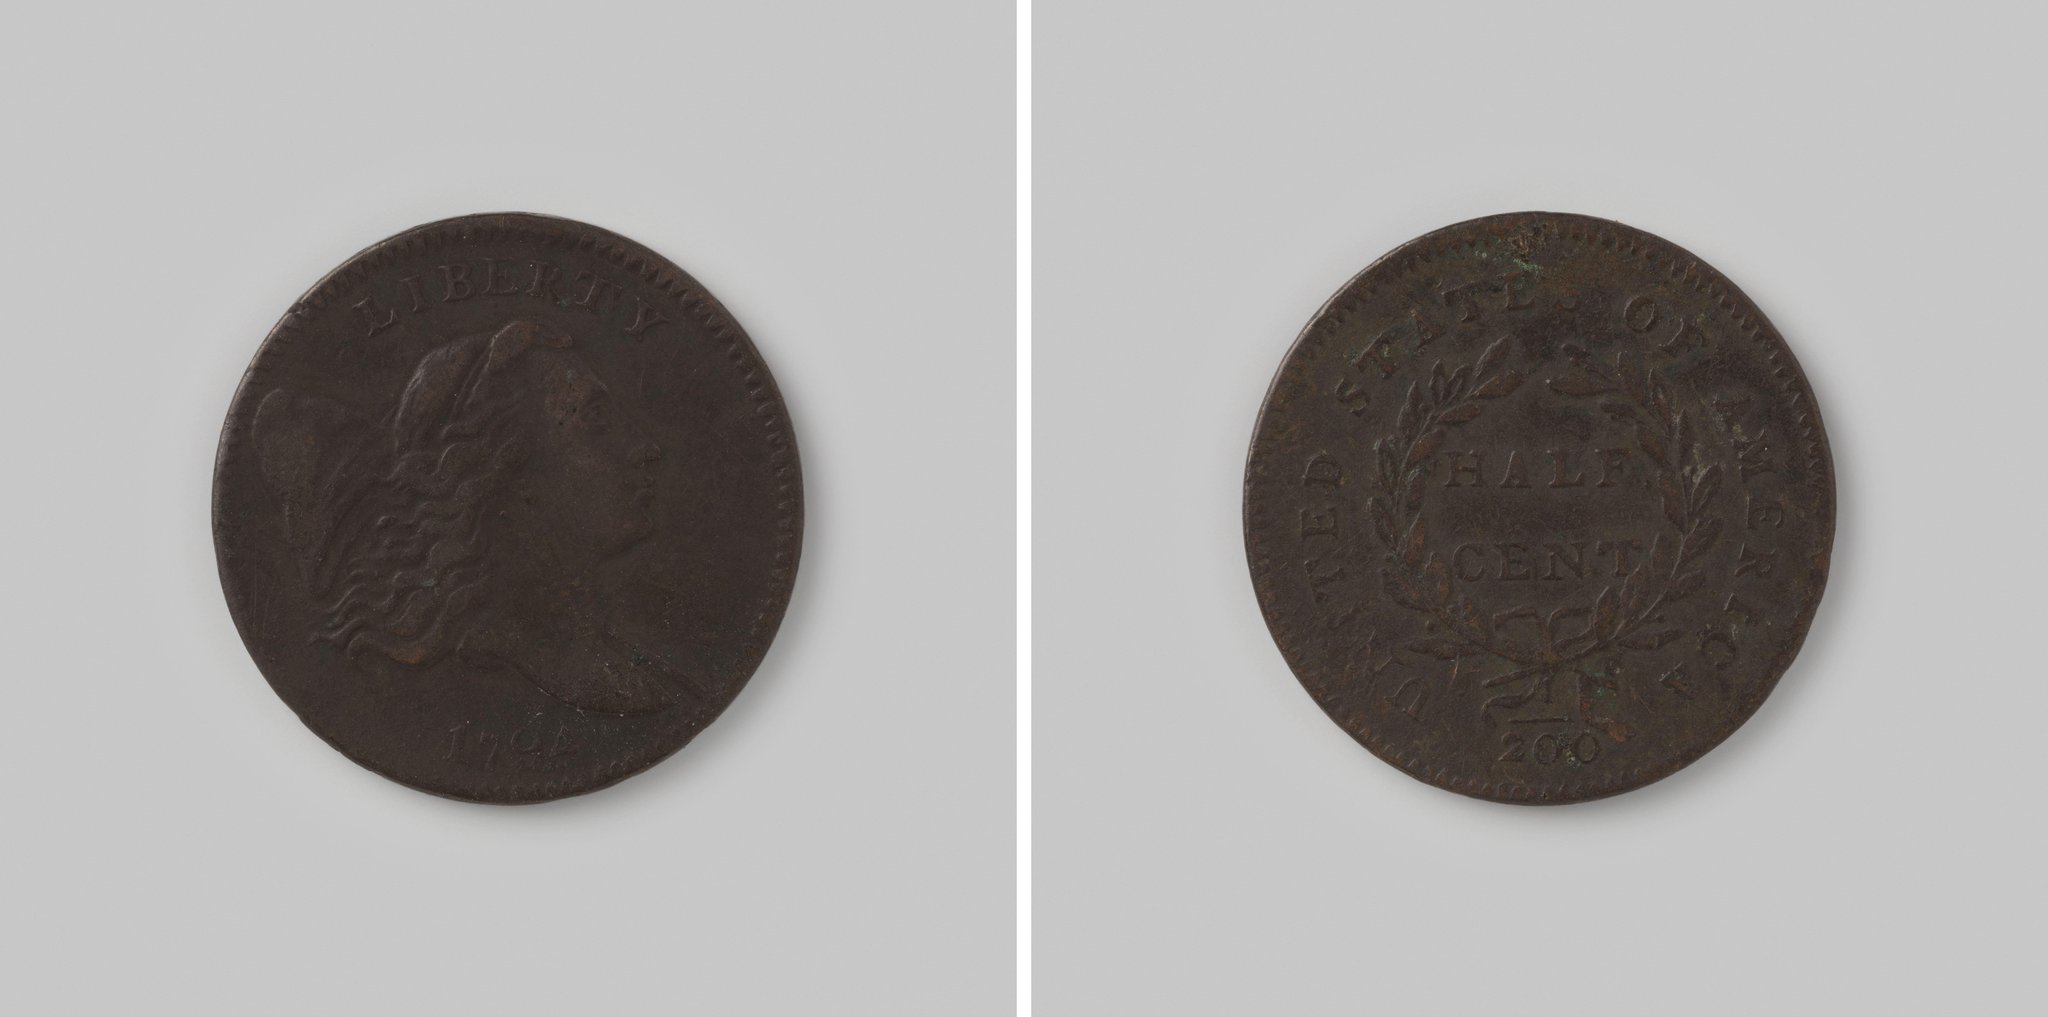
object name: coin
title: ½ cent uit de Verenigde Staten van Amerika, 1794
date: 1794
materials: copper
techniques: striking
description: Koperen munt. Voorzijde: liberty naar rechts met links van haar hoofd vrijheidshoed (cap). Onderaan jaartal. Keerzijde: tussen twee met grote strik samengebonden takken waarde-aanduiding: half cent in twee regels. Onderaan tussen linten waarde-aanduiding: 1/200. Randschrift.